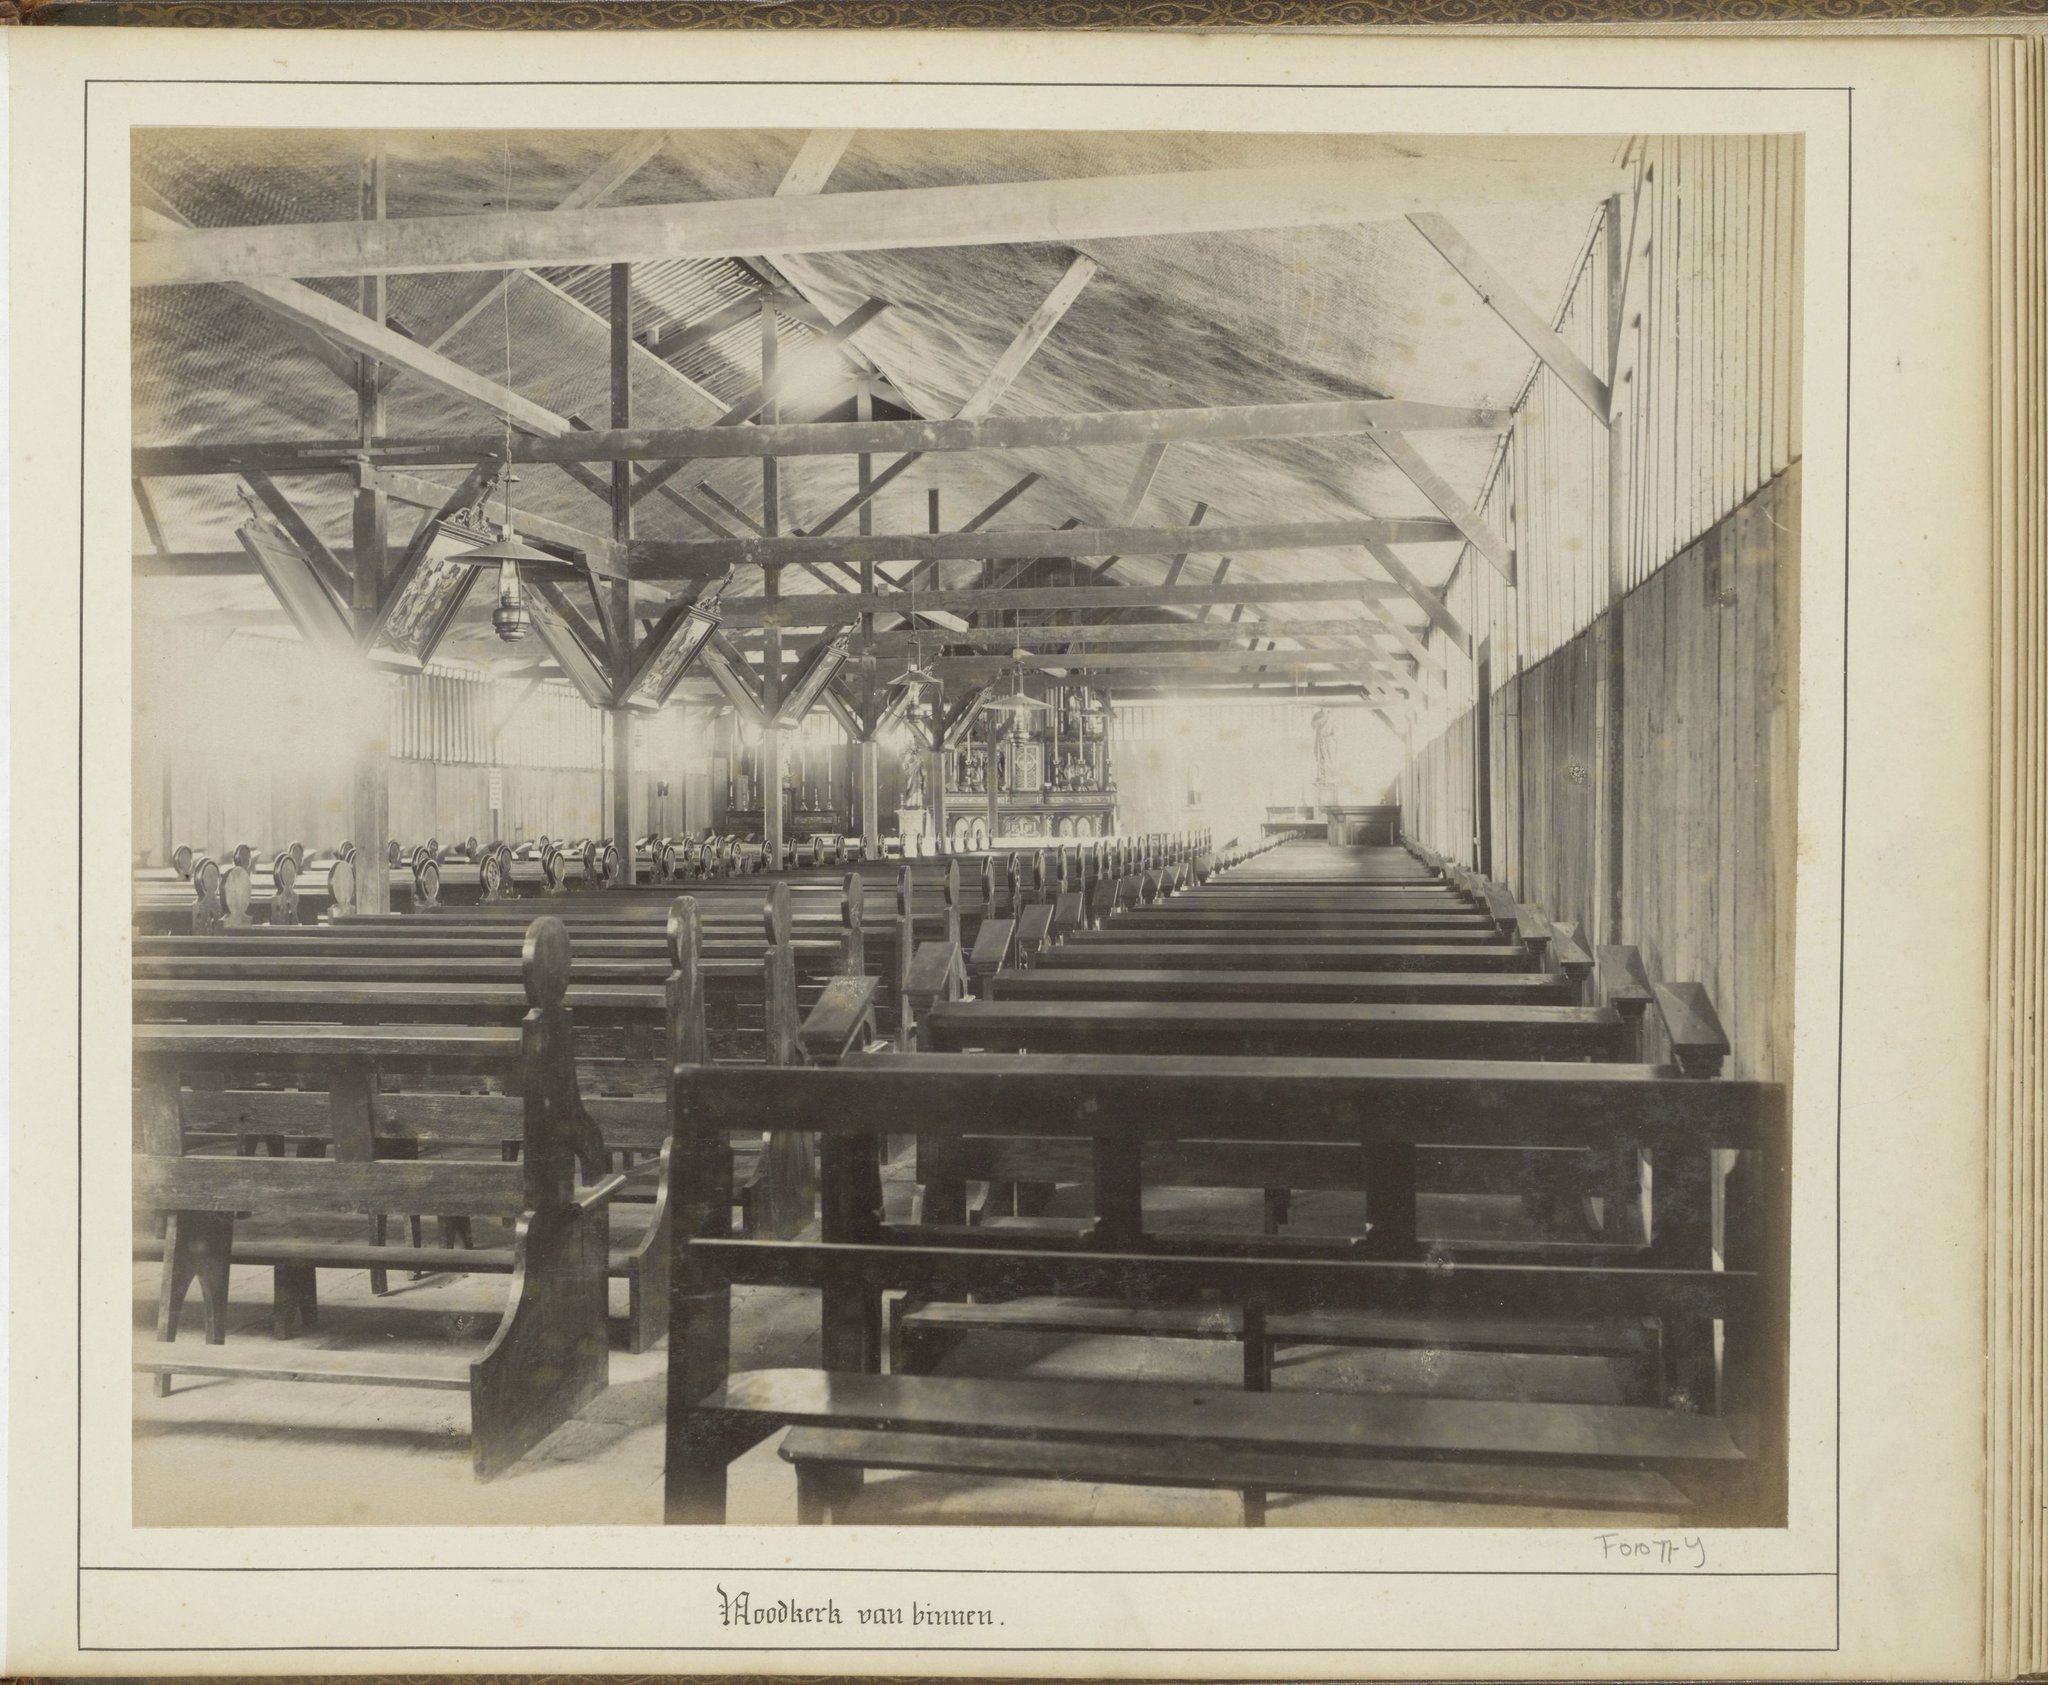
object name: album leaf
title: Interieur van de noodkerk in Batavia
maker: Anonymous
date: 1890-1910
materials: cardboard, photographic support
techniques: albumen print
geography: batavia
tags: parts of church interior (seats), parts of church interior: nave, interior of church, batavia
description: De noodkerk werd gebouwd na het instorten van een deel van de rooms-katholieke kerk in Batavia in 1890. Onderdeel van Album met foto's van Batavia.